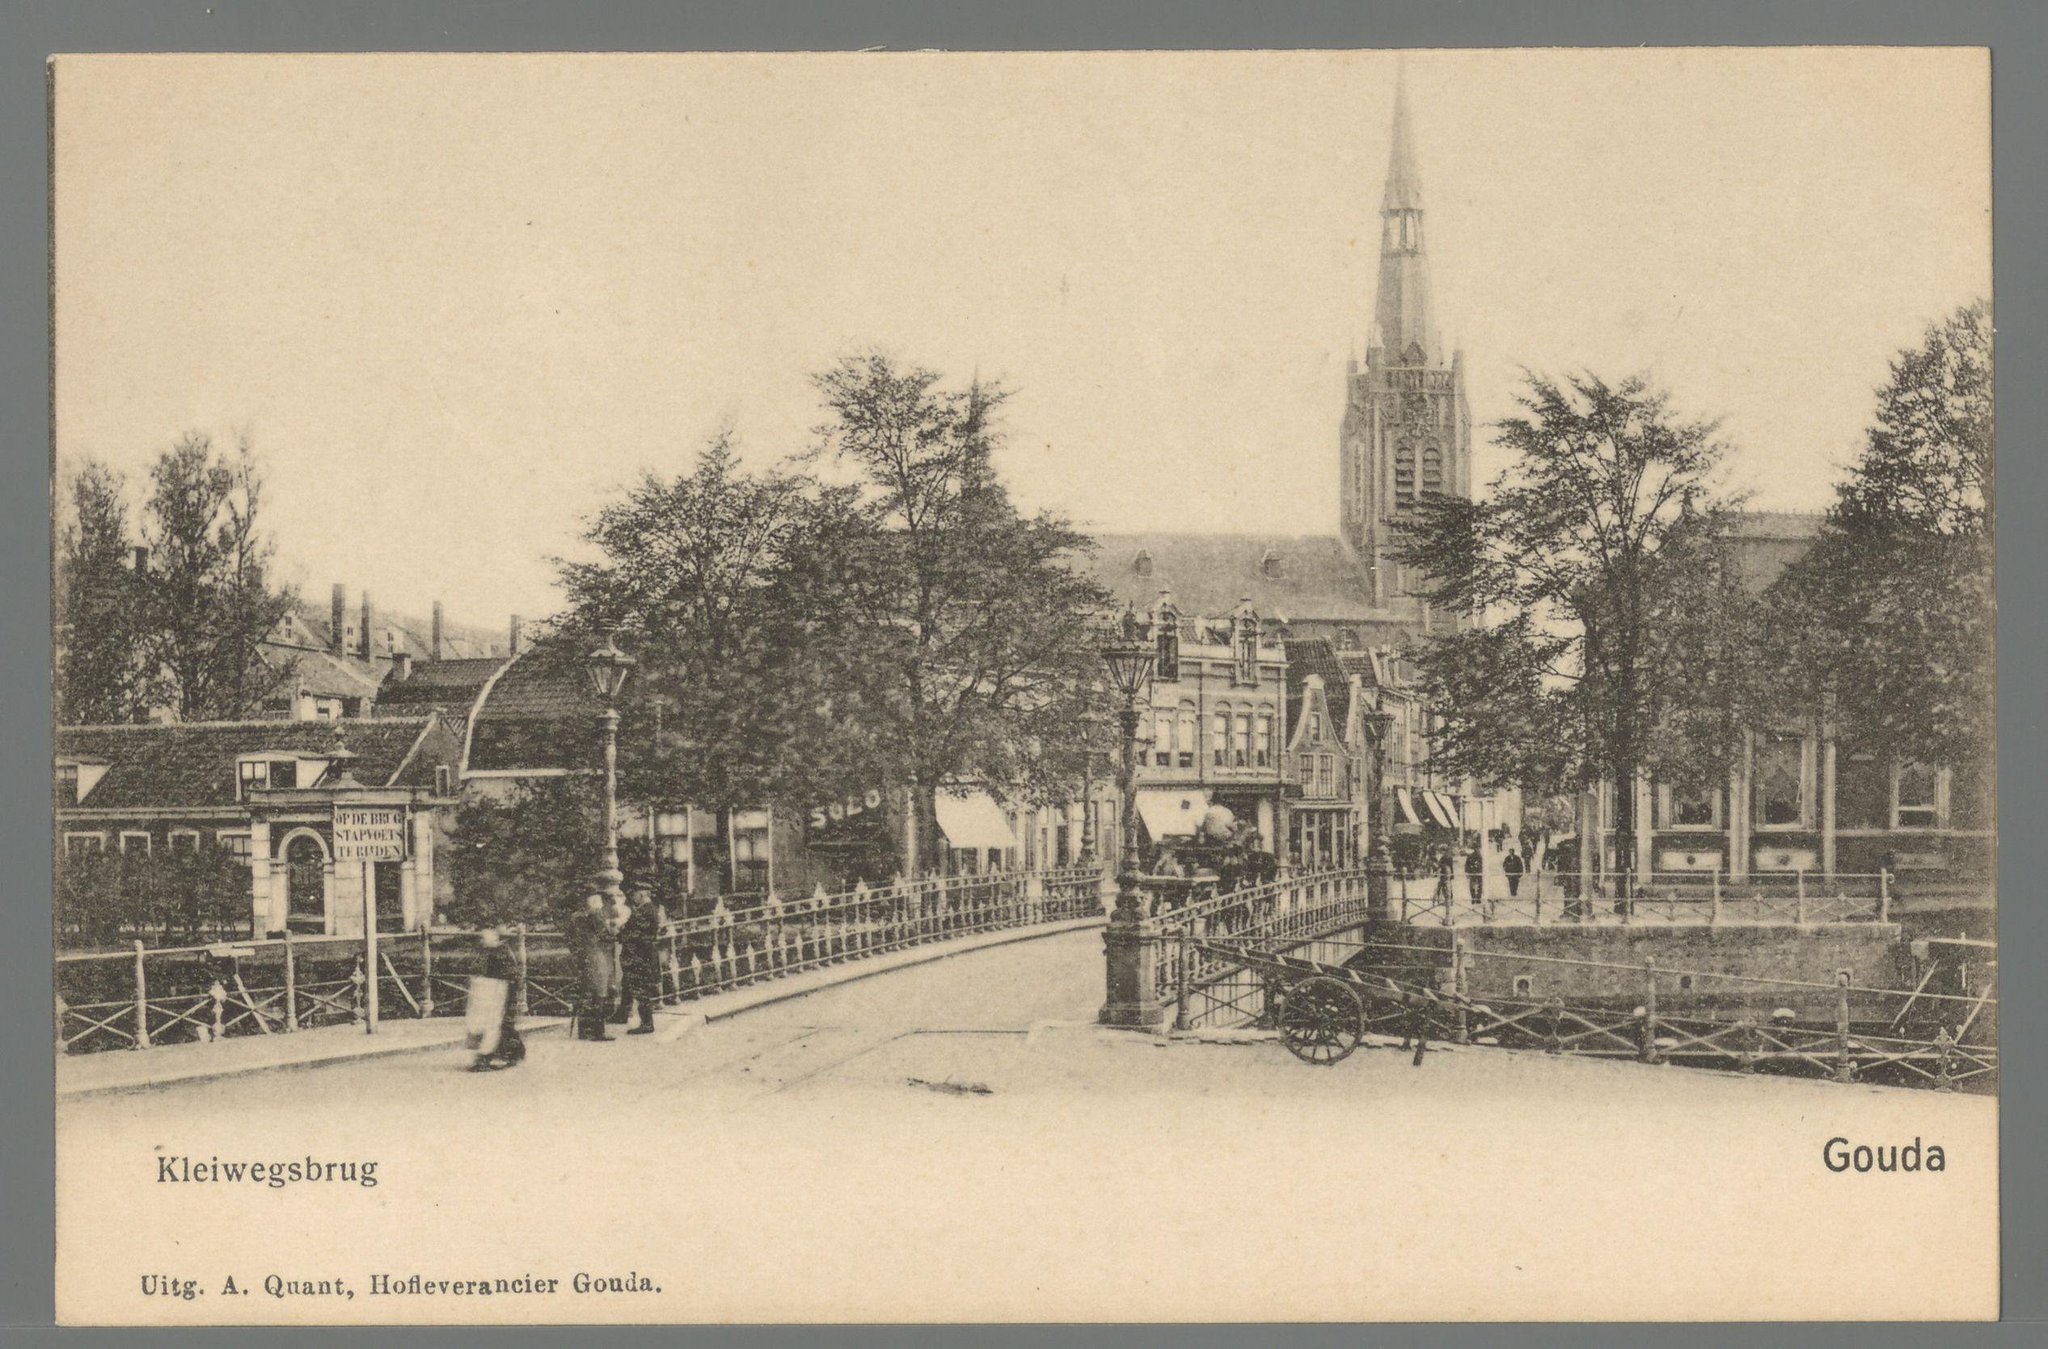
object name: ansichtkaart, prentbriefkaart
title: Kleiwegsbrug Gouda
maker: Anonymous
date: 1897-1905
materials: cardboard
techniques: photograph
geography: gouda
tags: bridge in city across river, canal, etc., gouda